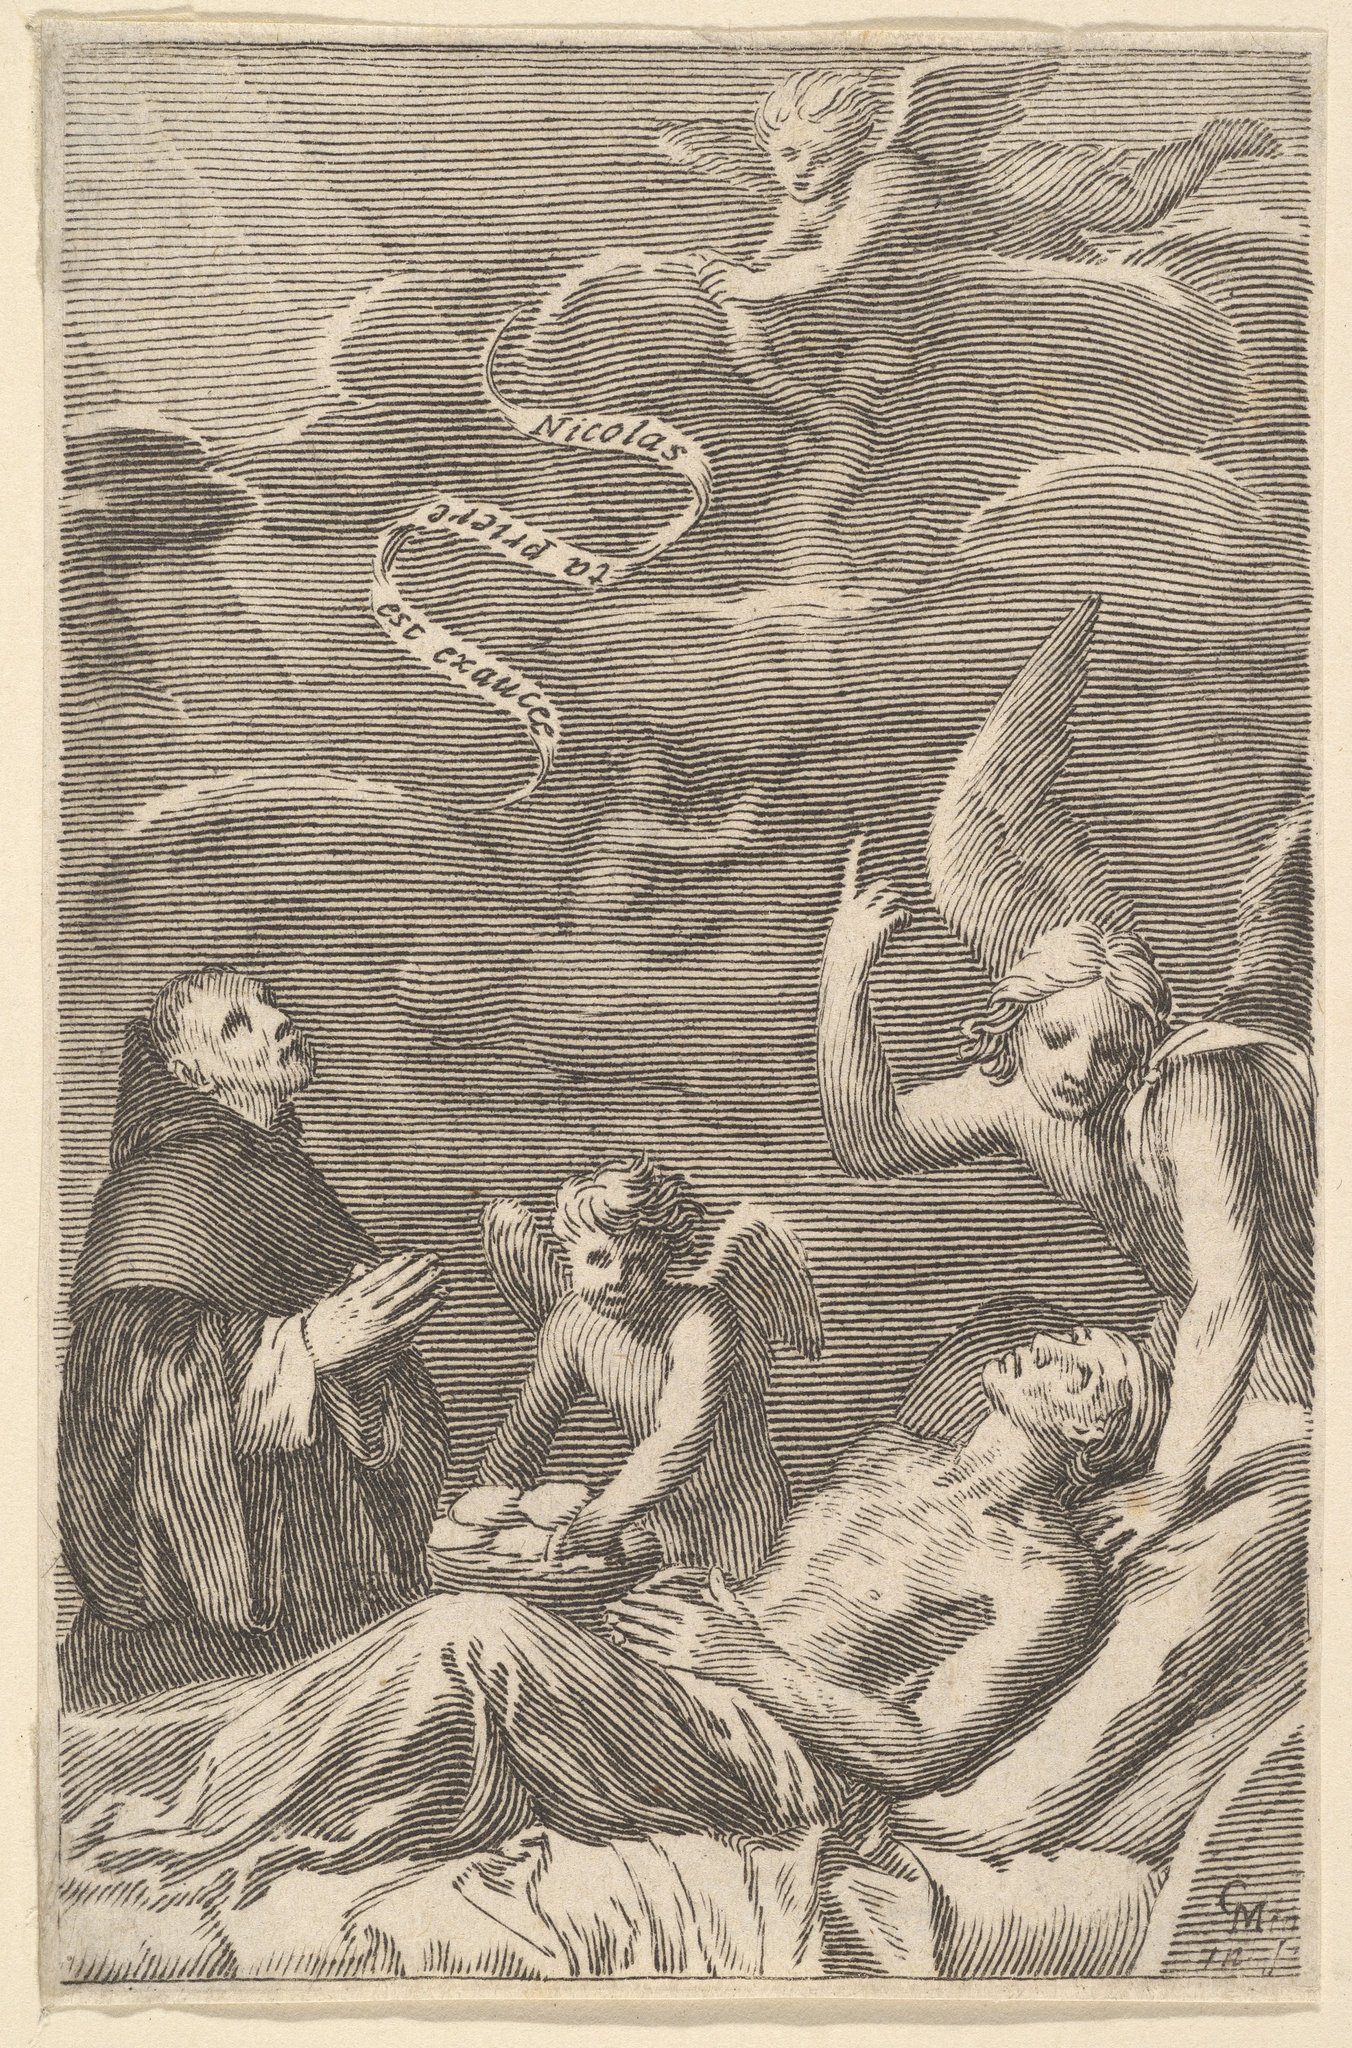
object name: print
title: St. Nicolas Praying for a Dying Man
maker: claude mellan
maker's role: artist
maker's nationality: french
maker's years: 1598-1688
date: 1600-1688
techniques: engraving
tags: men,angels,saints